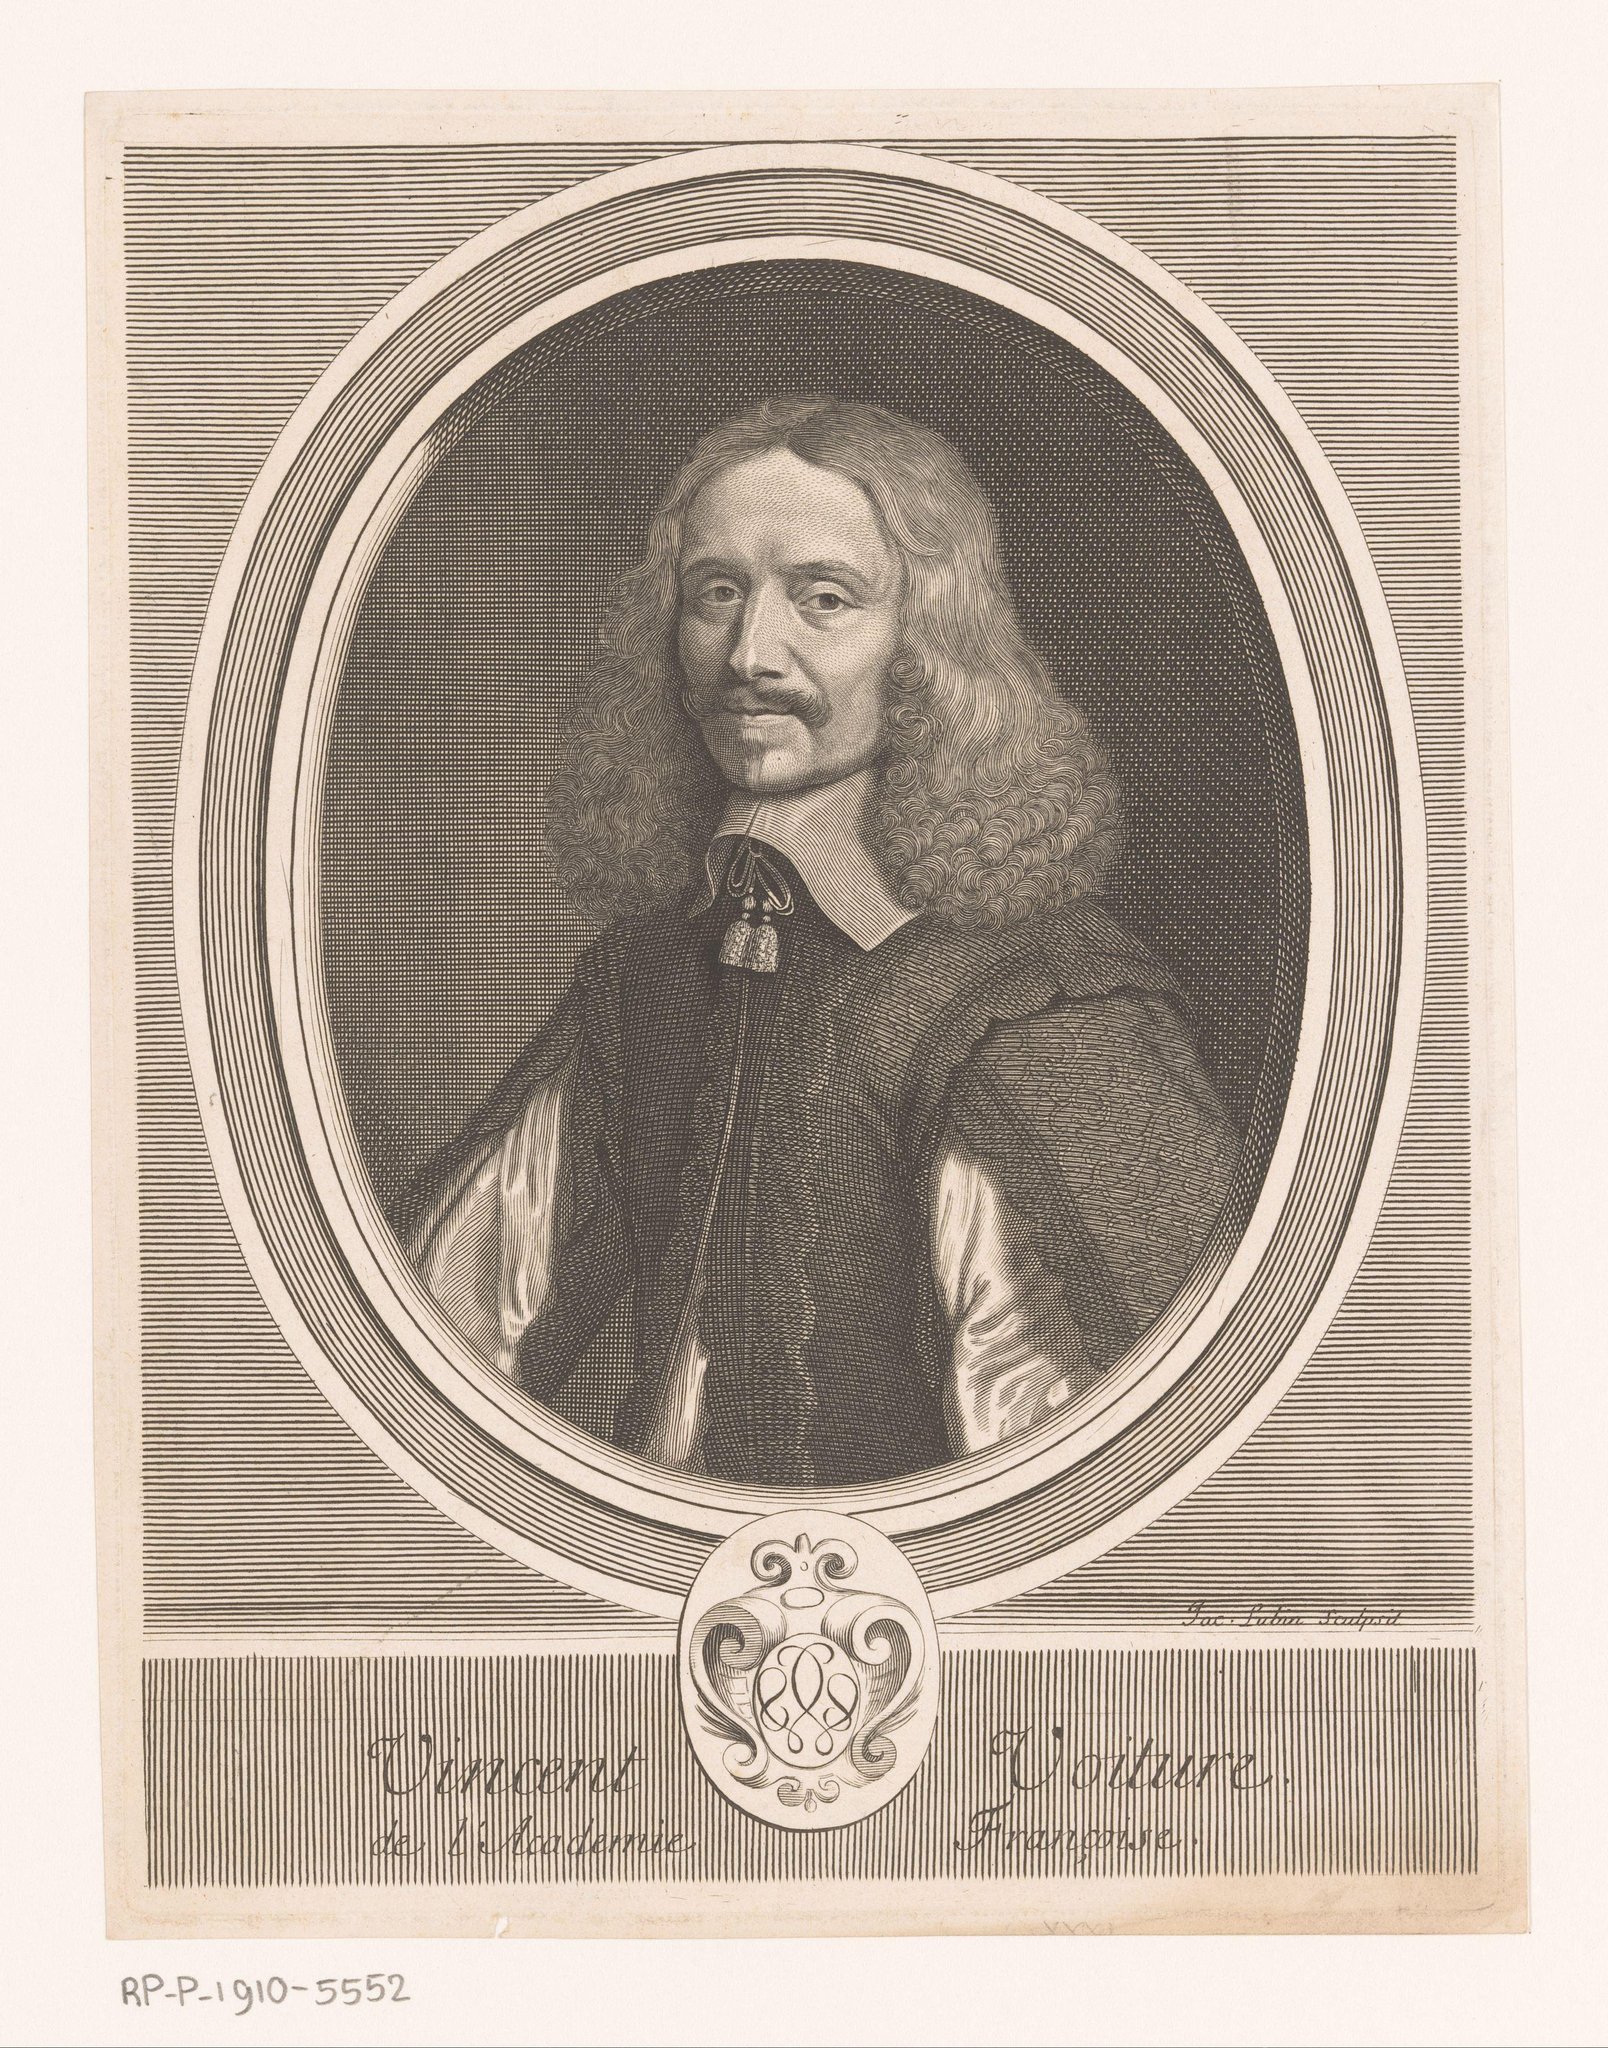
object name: print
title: Portret van Vincent Voiture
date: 1696-1700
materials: paper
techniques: engraving, etching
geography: paris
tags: paris, historical persons, portrait of a writer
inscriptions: collector's mark: Lugt 2228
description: Prent uit: Perrault, Charles. Les hommes illustres qui ont paru en France pendant ce siècle. Parijs: Antoine Dezallier, 1696-1700.